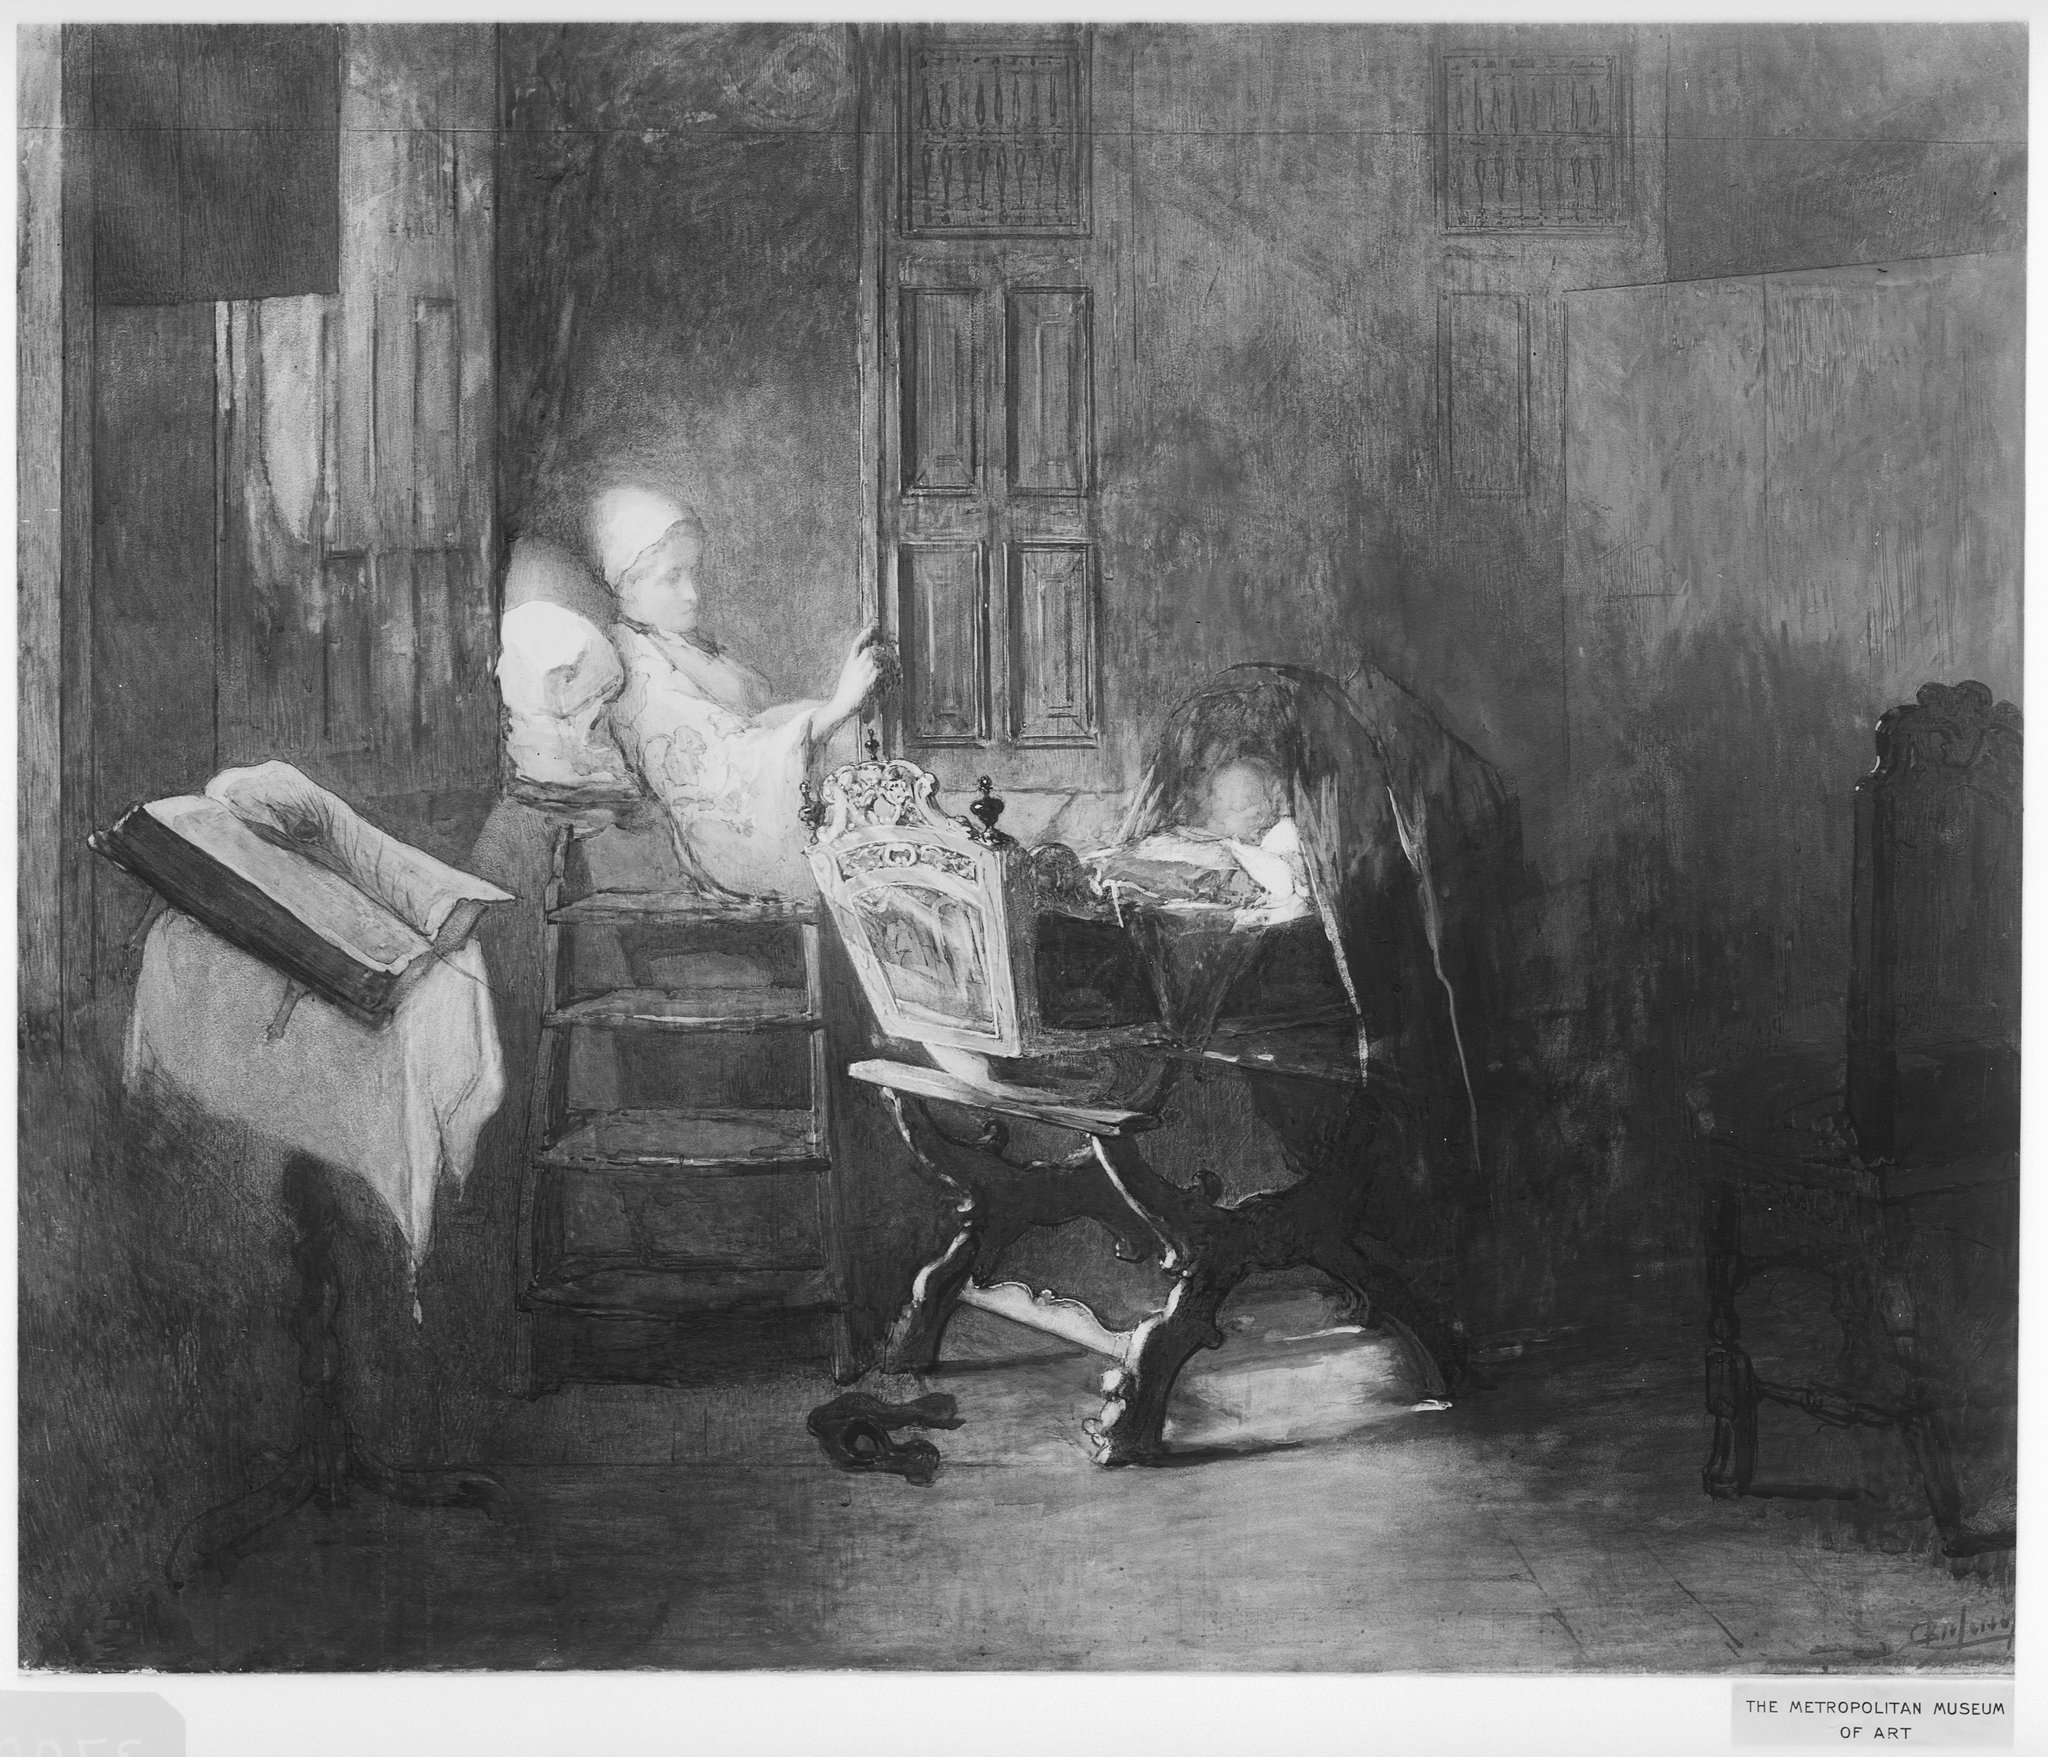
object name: drawing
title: The Sunbeam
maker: christoffel bisschop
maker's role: draughtsman, print maker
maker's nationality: dutch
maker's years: 1828-1904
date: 1834-1933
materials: watercolor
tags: interiors,infants,women,cradles,chairs